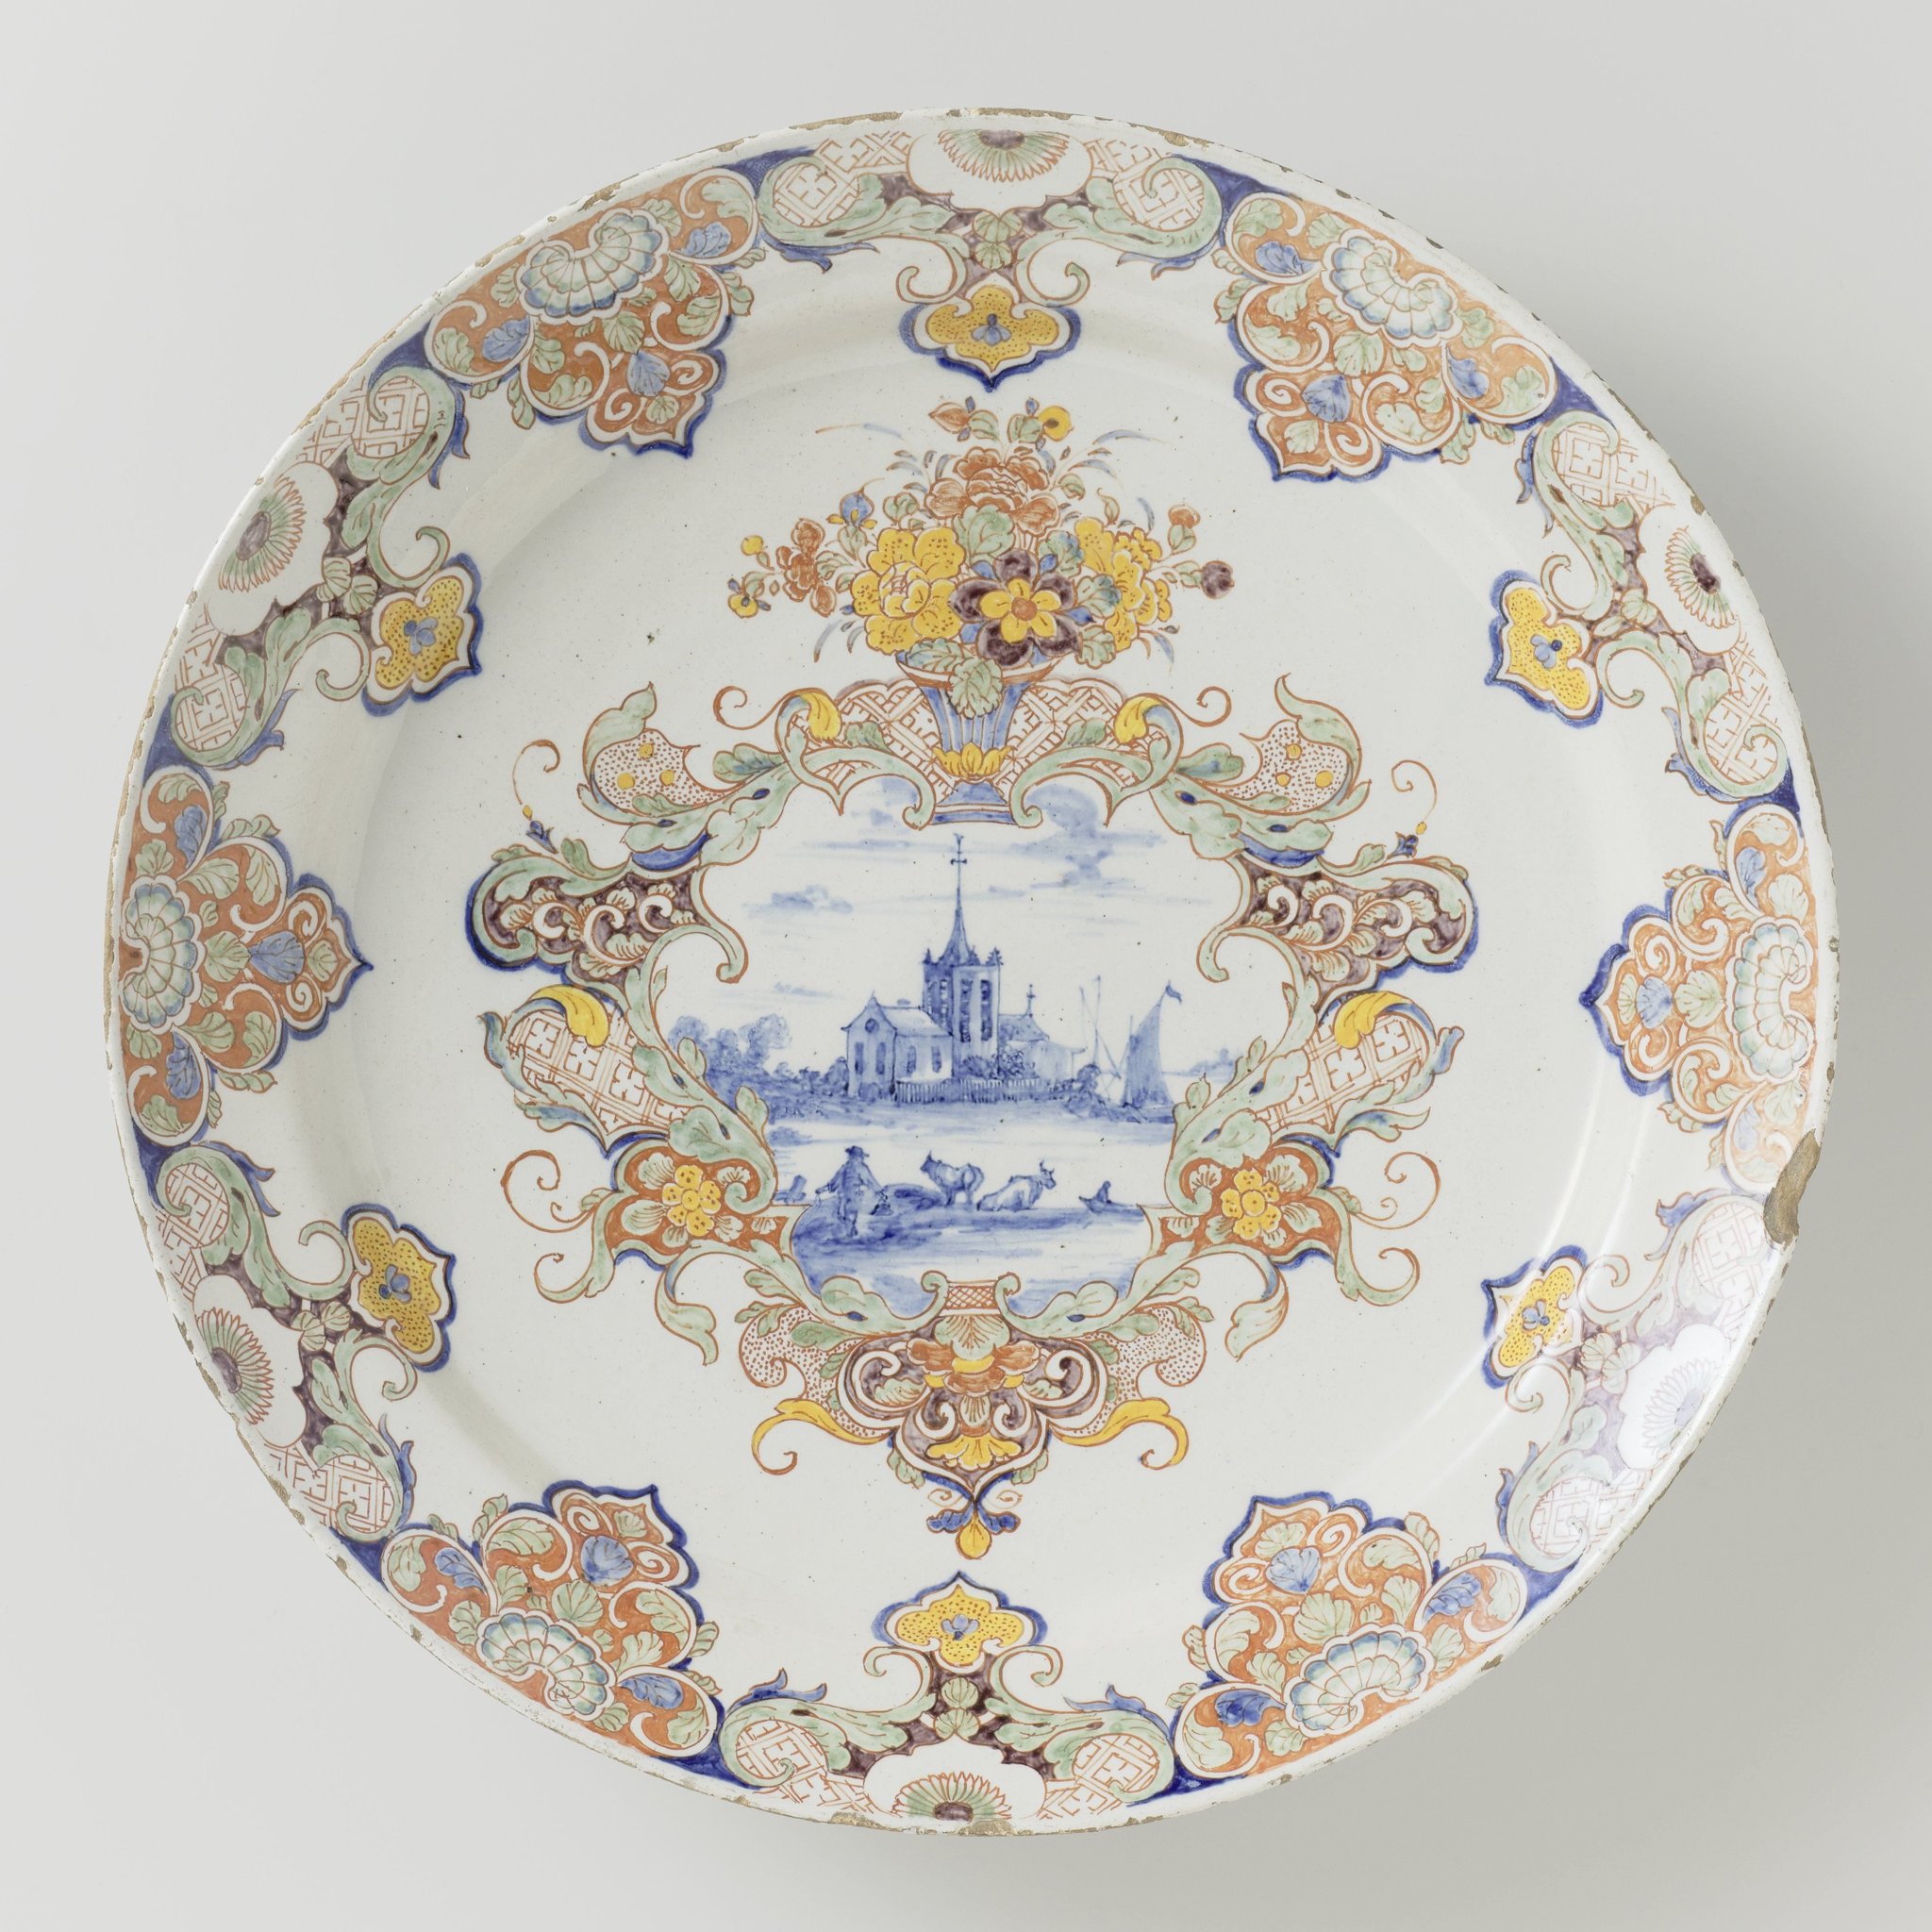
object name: platter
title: Schotel van veelkleurig beschilderde faïence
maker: Anonymous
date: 1740-1780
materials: faience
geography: delft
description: Schotel van faïence. Beschilderd met een landschap in blauw binnen een cartouche. Daar omheen veelkleurige lambrequinsranden.